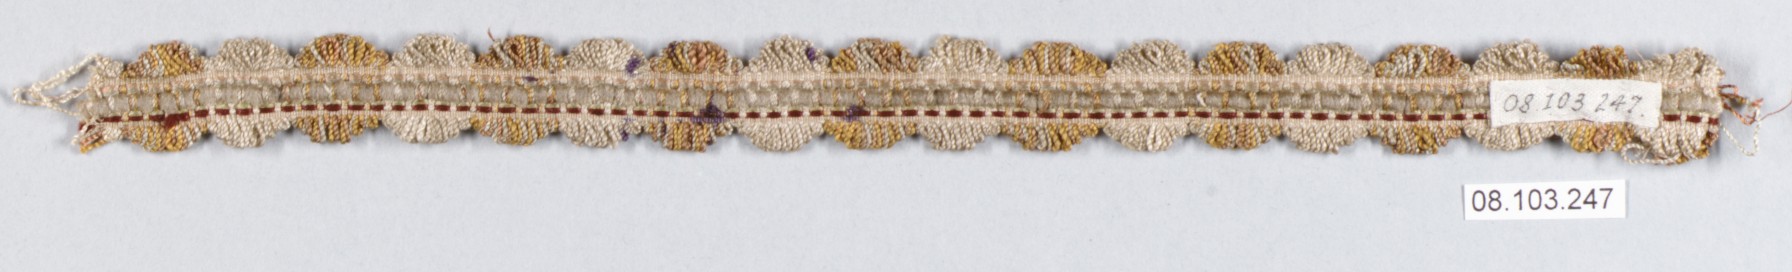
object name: gimp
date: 1801-1900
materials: silk